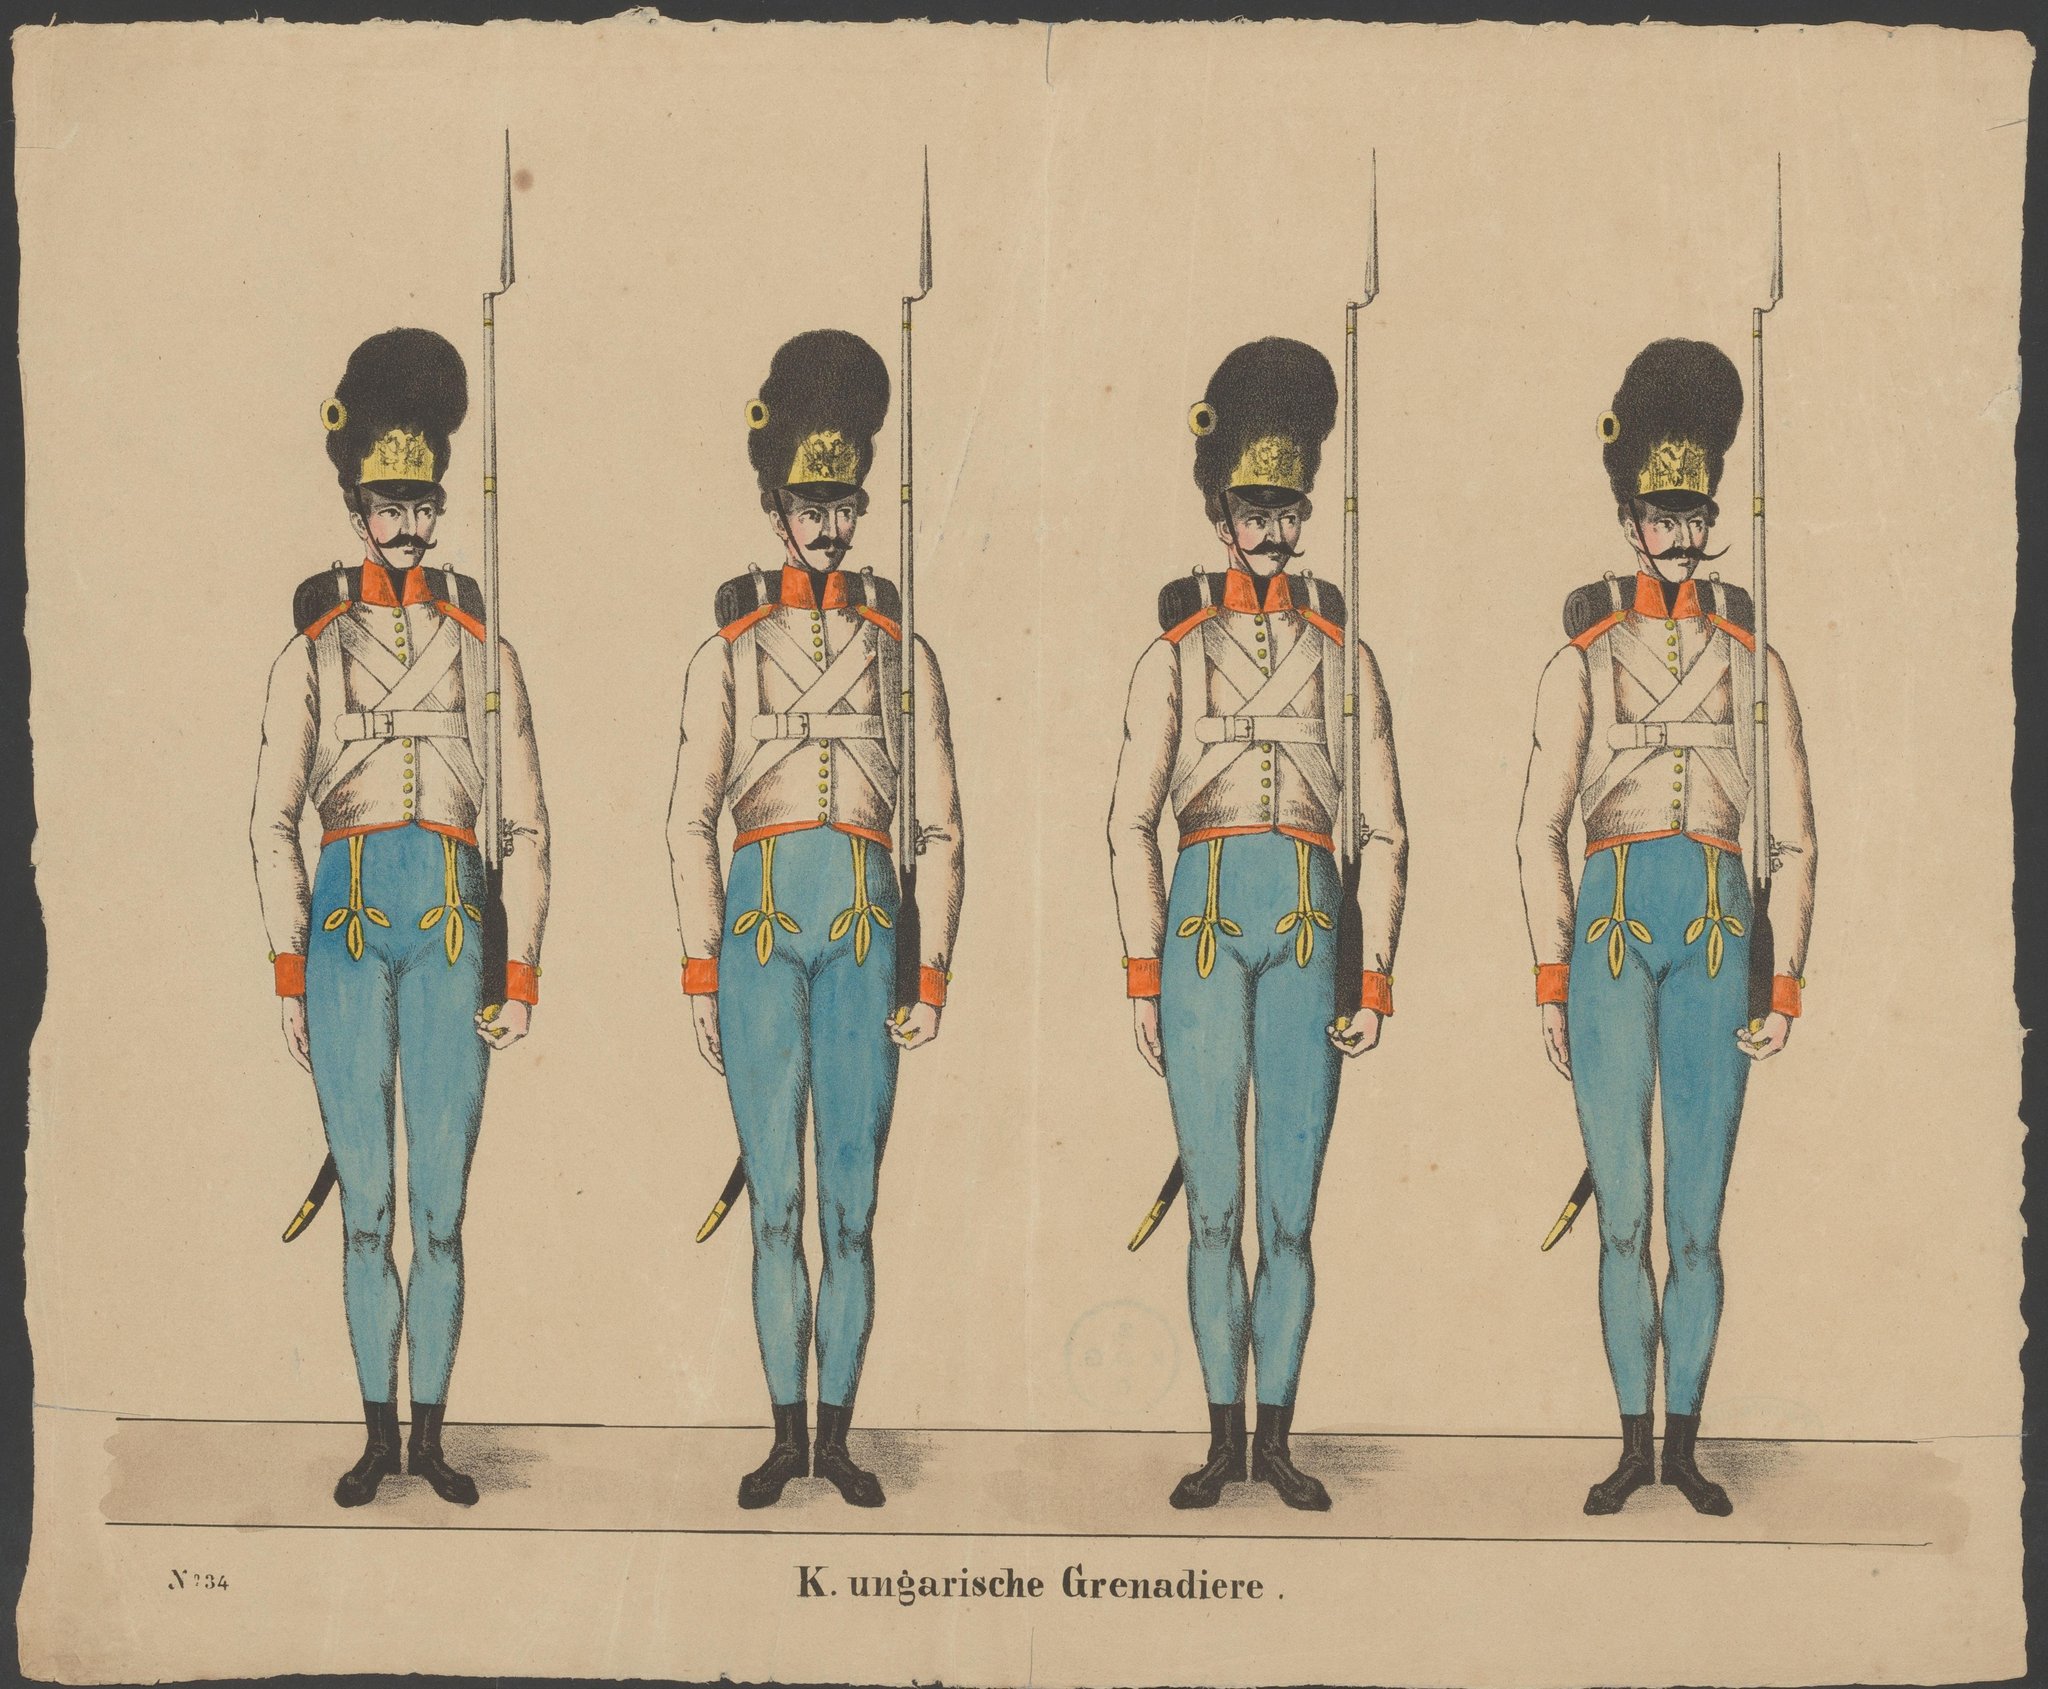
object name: print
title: K. ungarische Grenadiere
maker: Anonymous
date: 1800-1899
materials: paper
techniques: hand coloring, lithograph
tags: the company, the unit, the troop ~ military service, the soldier; the soldier's life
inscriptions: stamp, collector's mark: Lugt 1641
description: Linksonder genummerd: No. 34. Onderwerpsrubrieken binnen de Atlas Zeden en Gewoonten: Zeden en Gewoonten in Engeren Zin, Des menschen beging, midden en einde, Kinderleven – Kinderspel en Kinderprenten.